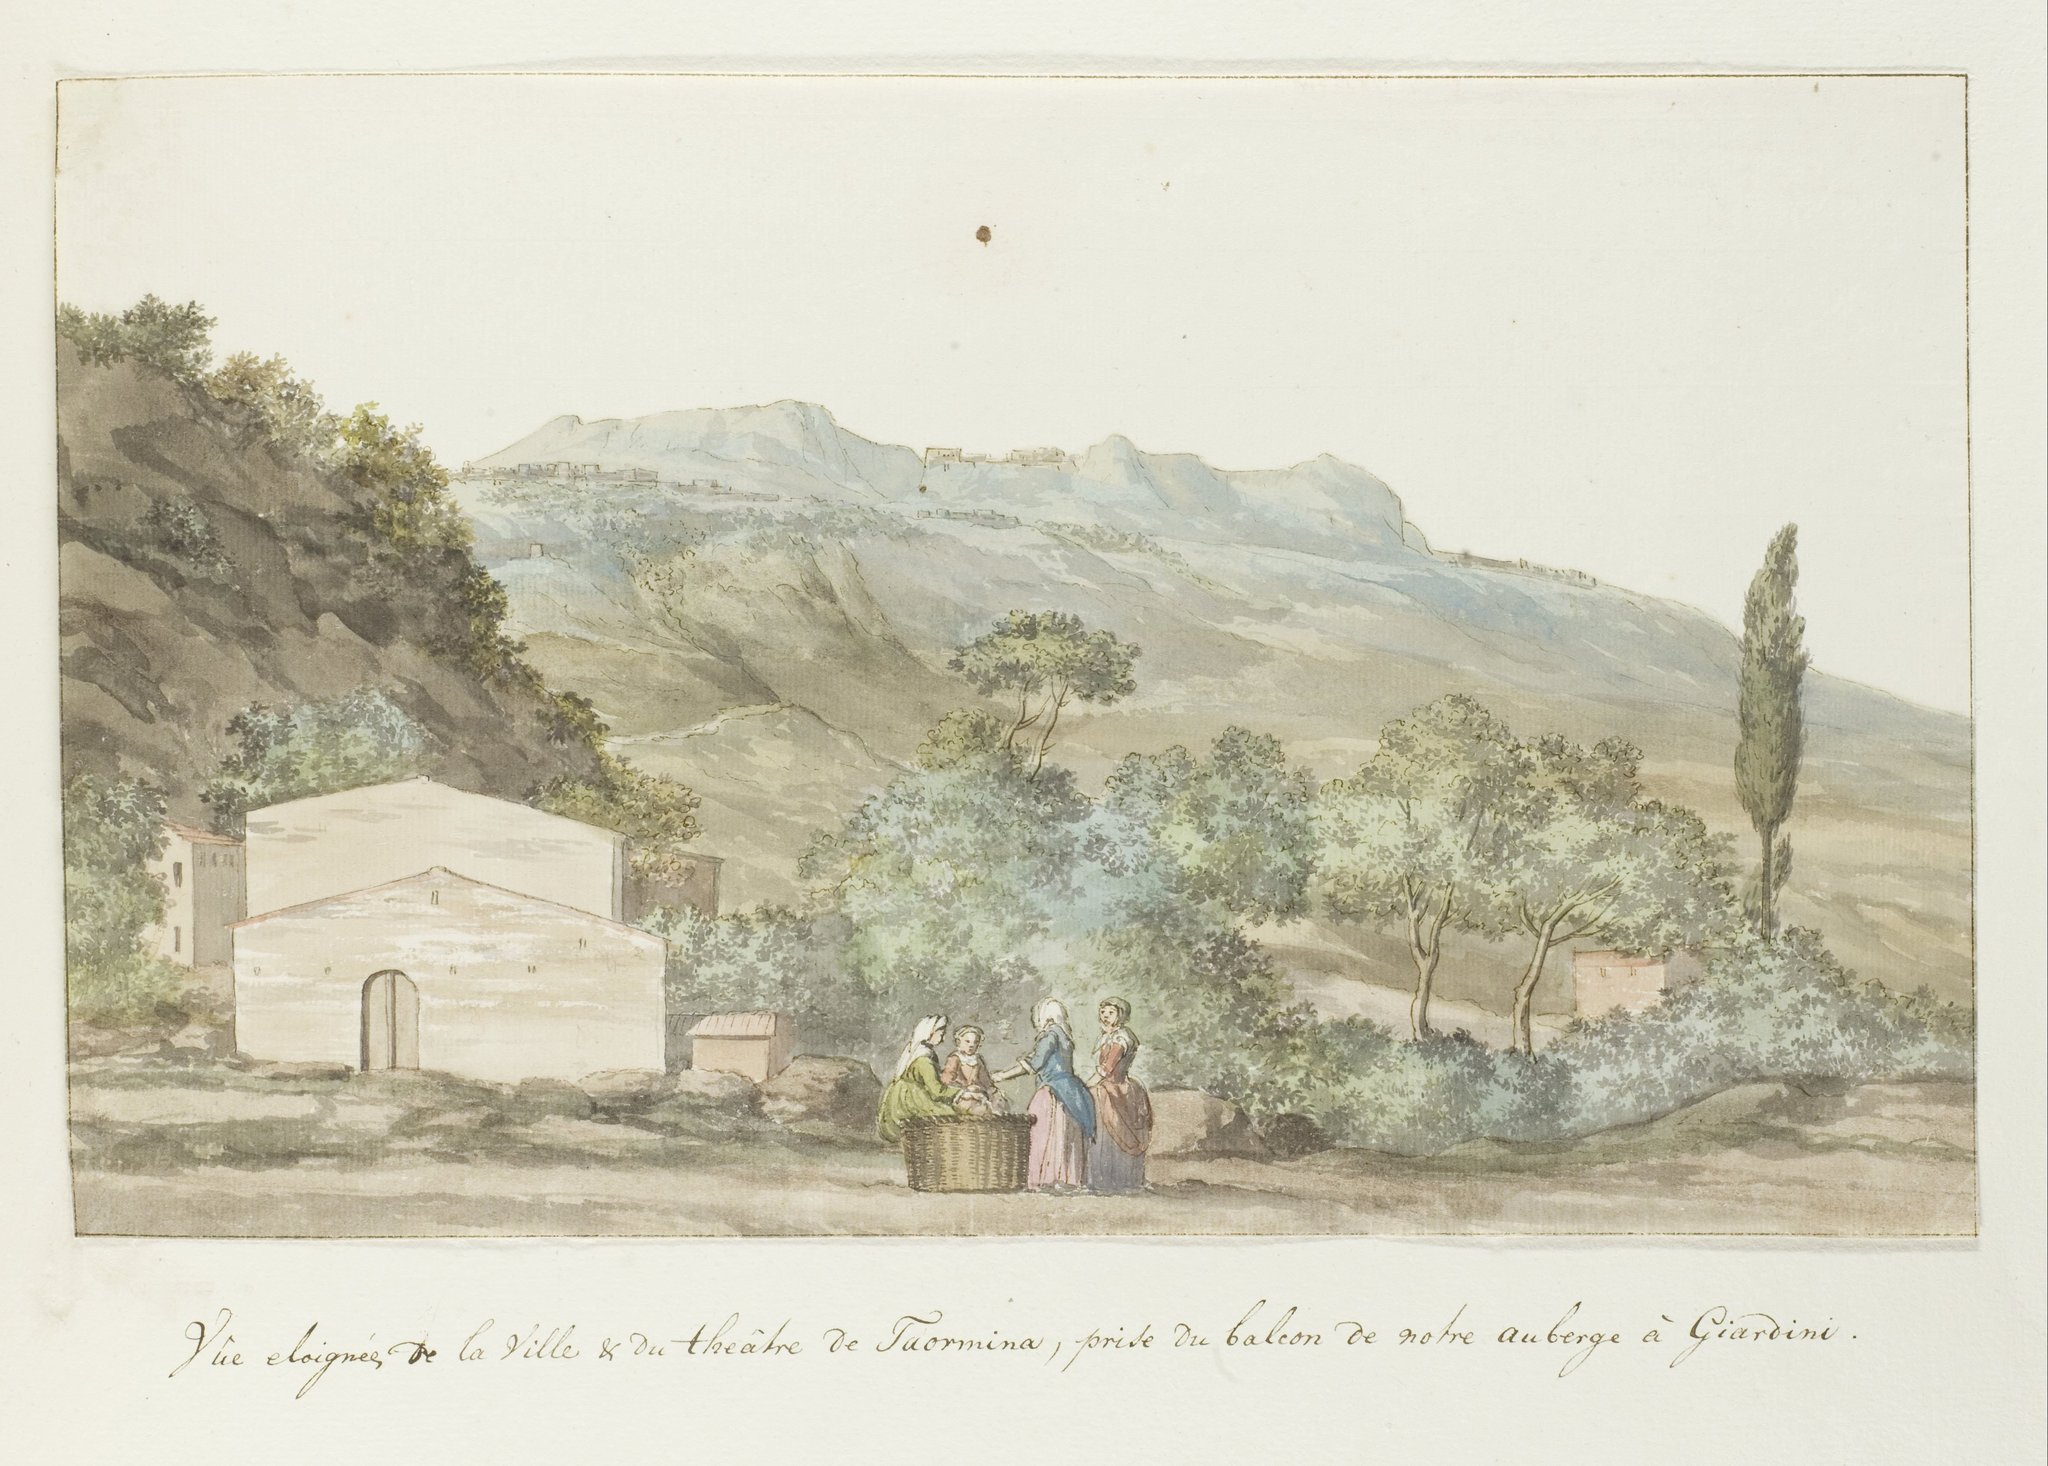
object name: watercolor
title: Gezicht op de stad en het theater van Toarmine vanaf balkon van herberg te Giardini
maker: louis ducros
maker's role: draughtsman, print maker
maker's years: 1748-1810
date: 1778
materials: chalk, paper, watercolor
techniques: brush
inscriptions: number: ‘No 153 Vue éloignée de la Ville et du théâtre de Taormina, prise du blacon de notre auberge à Giardini’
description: Tekening uit het album 'Voyage en Italie, en Sicile et à Malte', 1778.